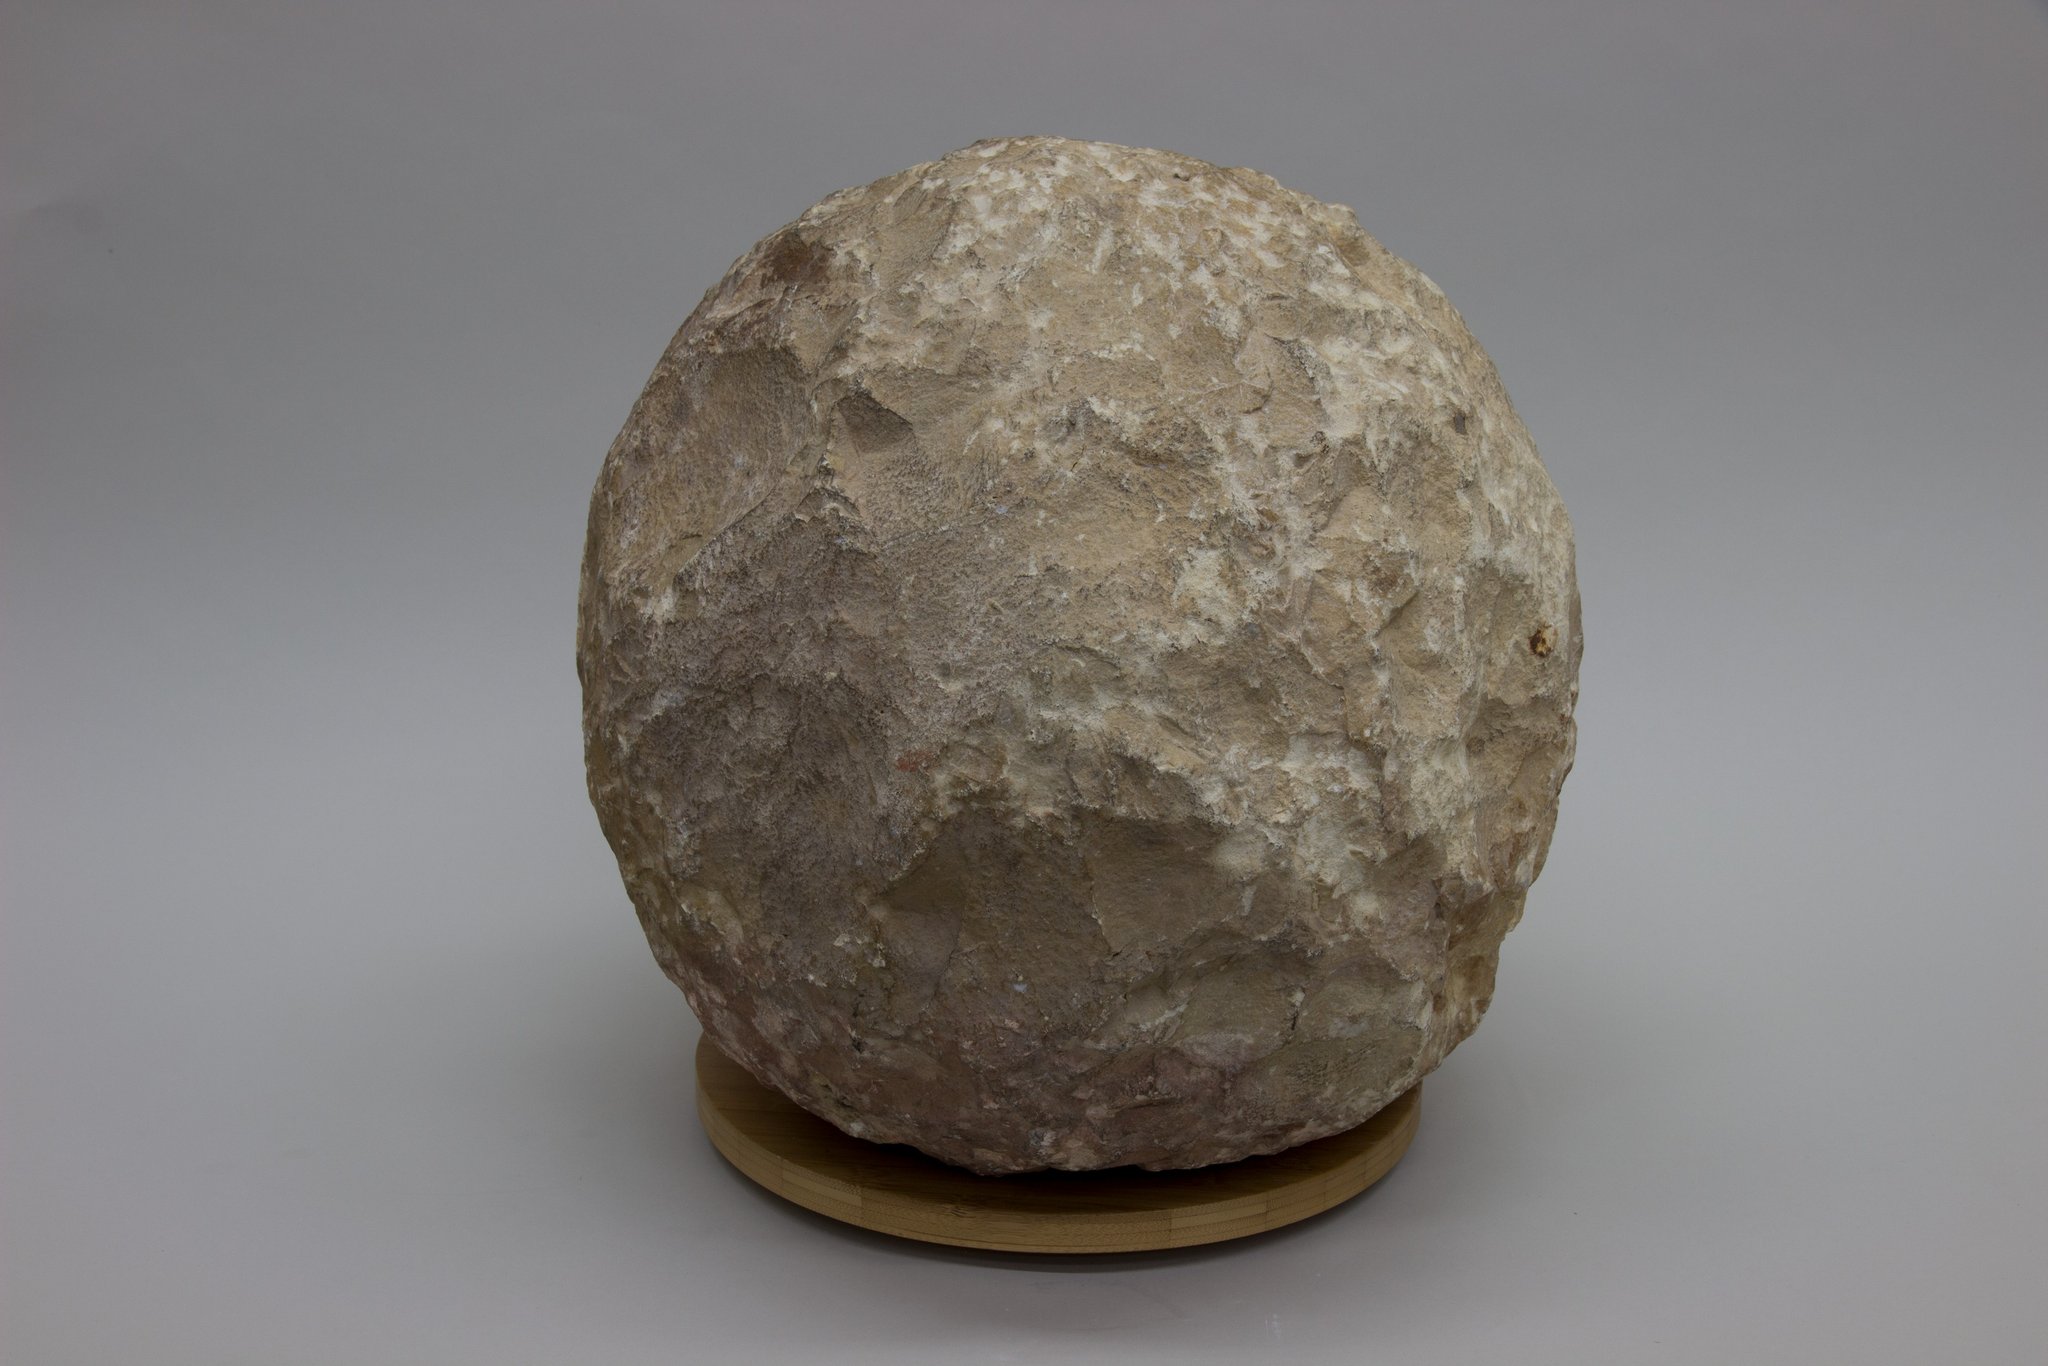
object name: catapult projectile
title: Catapult Projectile from Montfort (Starkenberg) Castle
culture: kingdom of jerusalem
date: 1250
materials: limestone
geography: israel